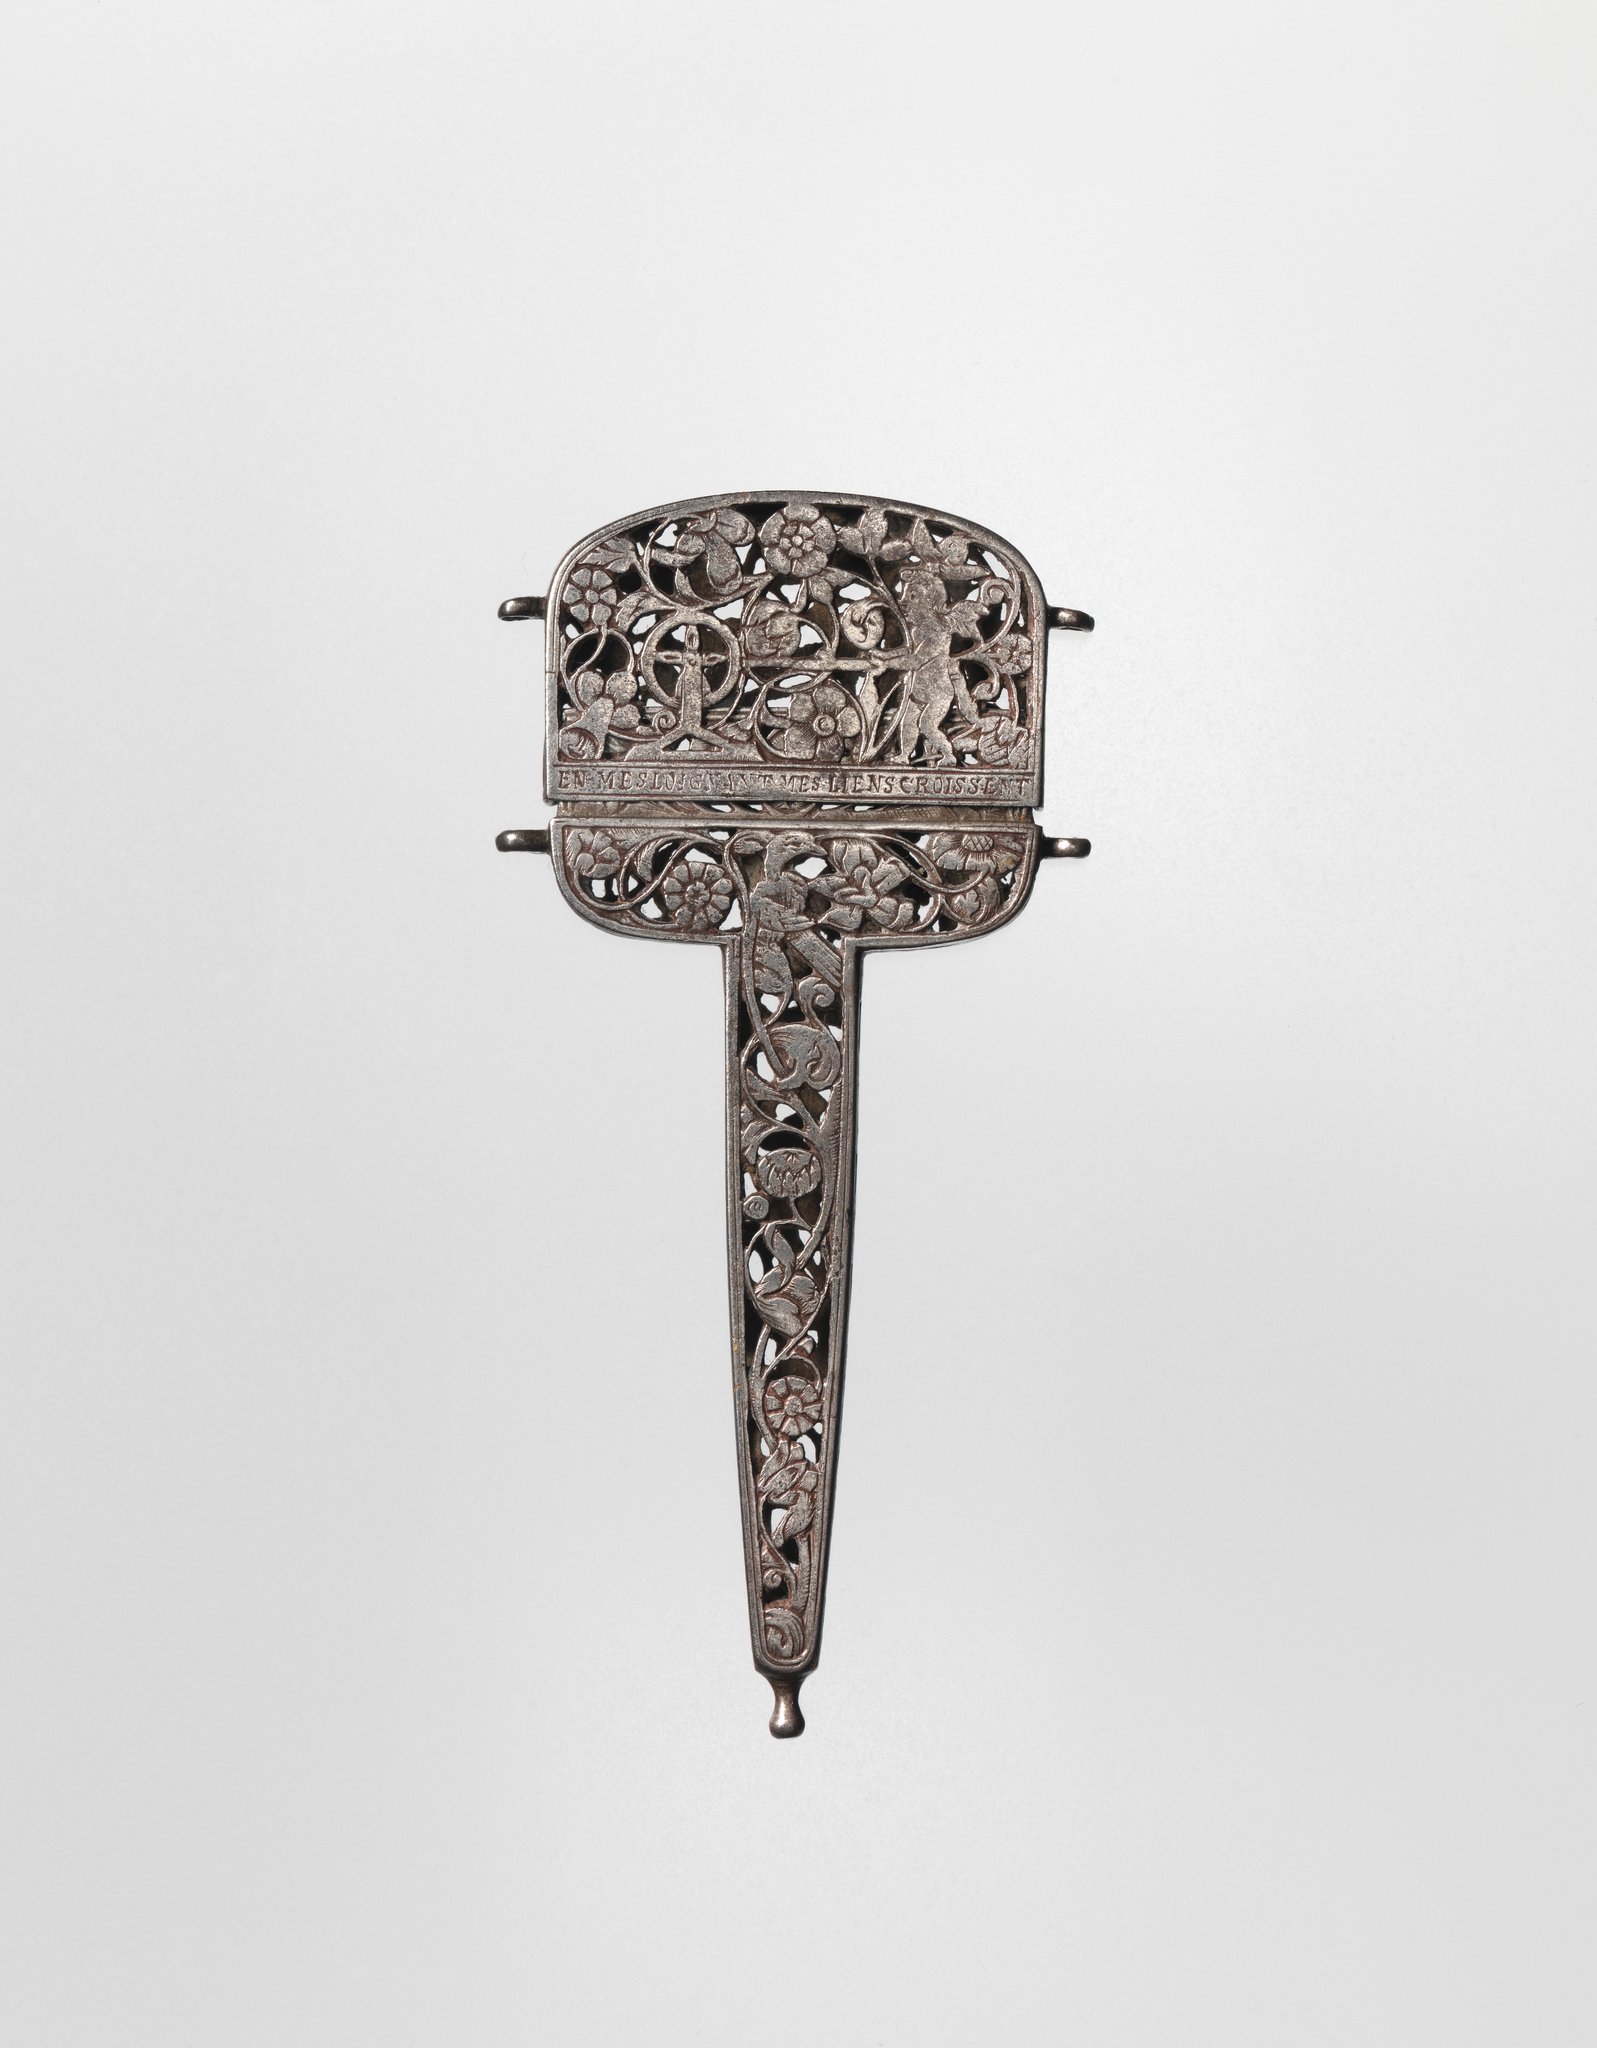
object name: scissors case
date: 1601-1700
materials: steel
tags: birds,putti,flowers